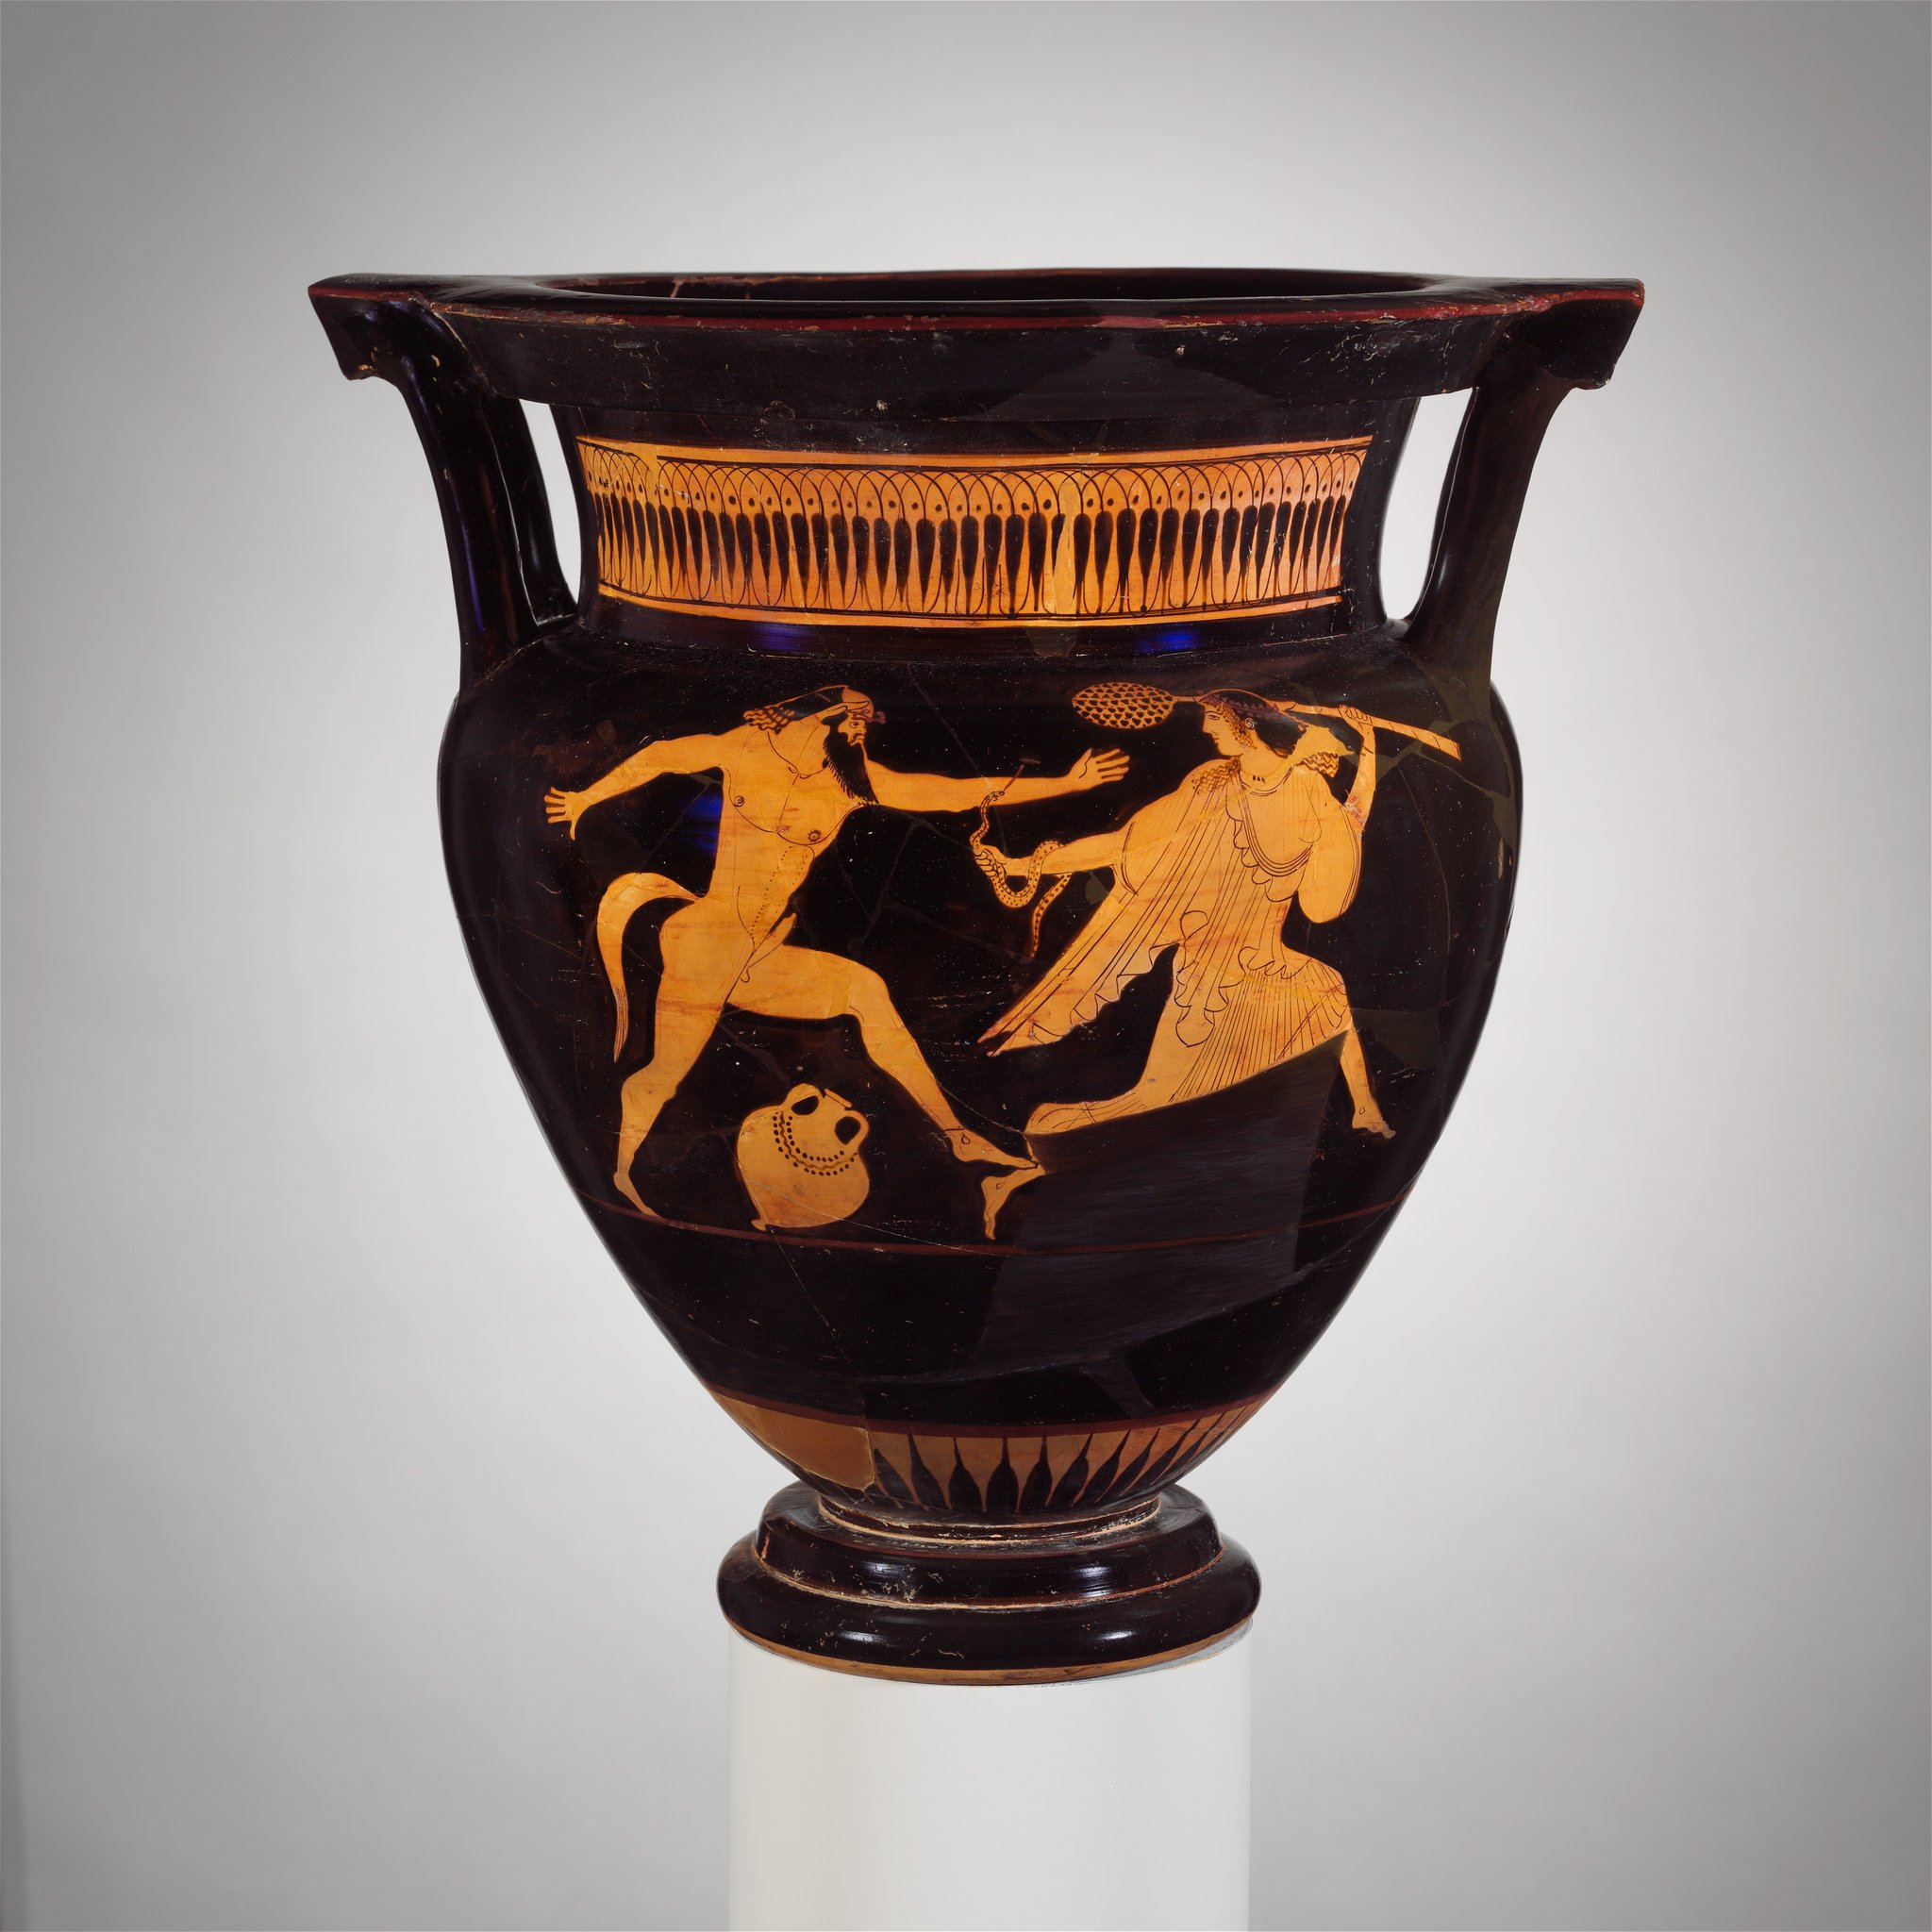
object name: column krater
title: Terracotta column-krater (bowl for mixing wine and water)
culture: greek, attic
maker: pig painter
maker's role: artist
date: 475-465 BCE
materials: terracotta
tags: maenads,satyrs